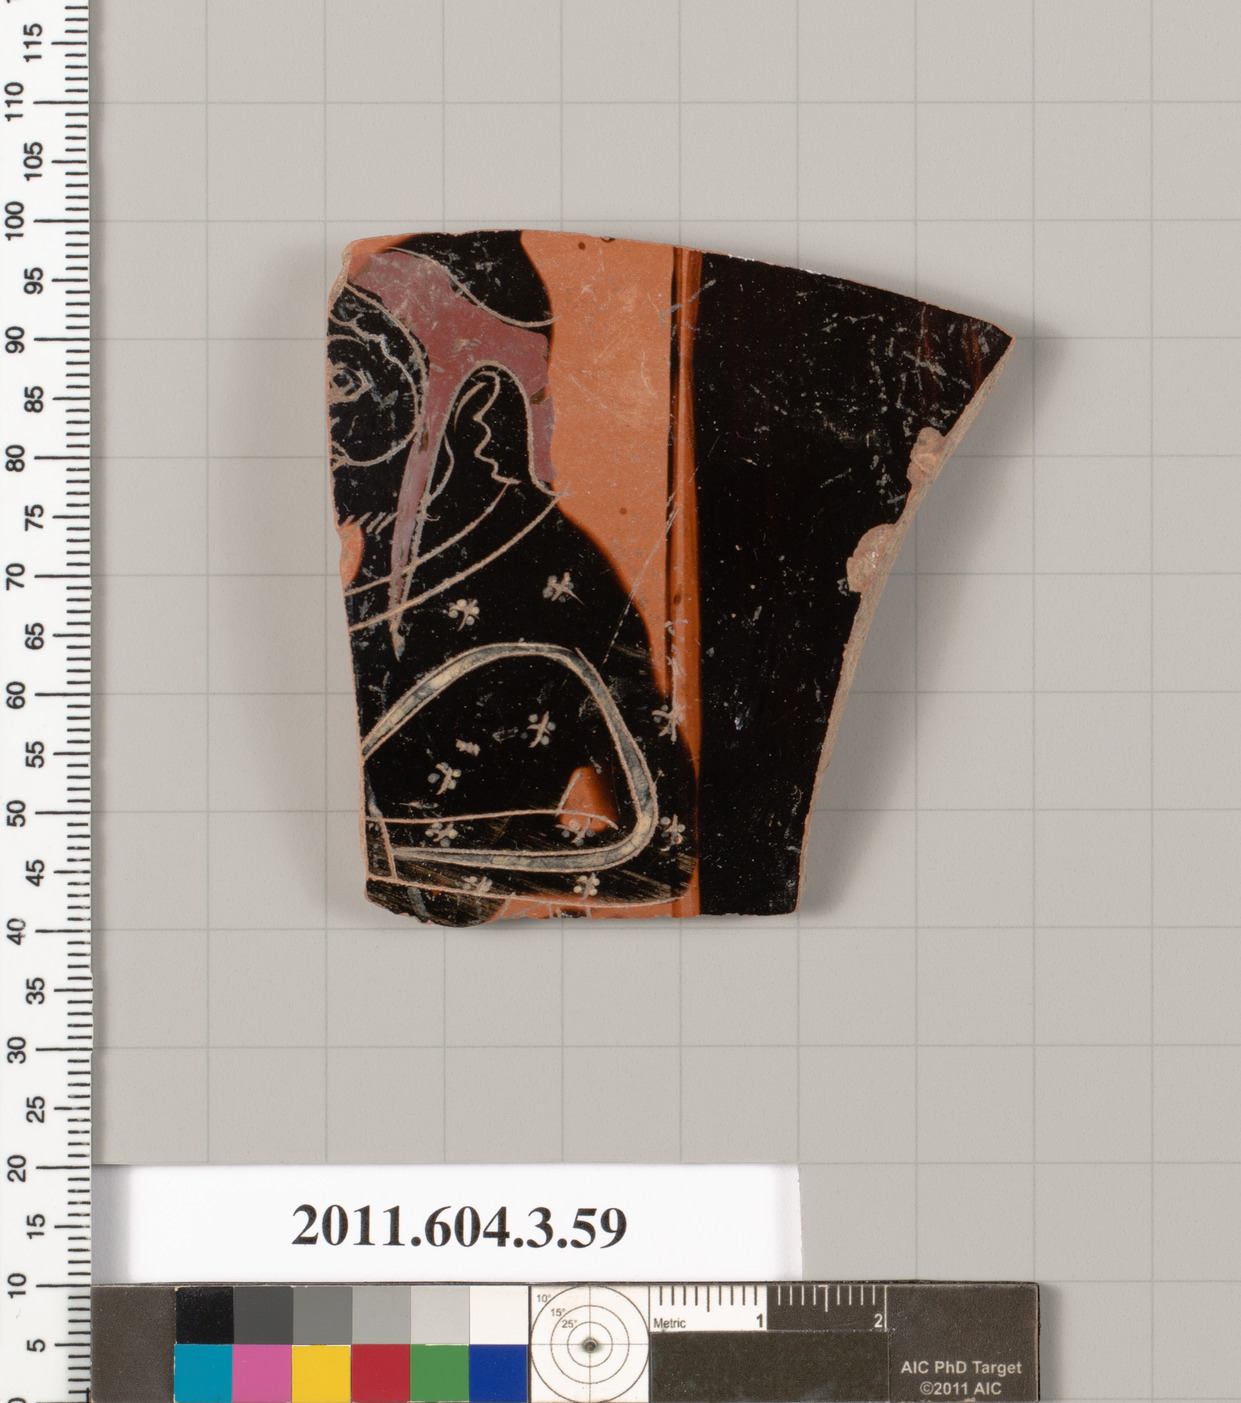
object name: amphora fragment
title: Terracotta fragment of an amphora (jar)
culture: greek, attic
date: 534-501 BCE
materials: terracotta